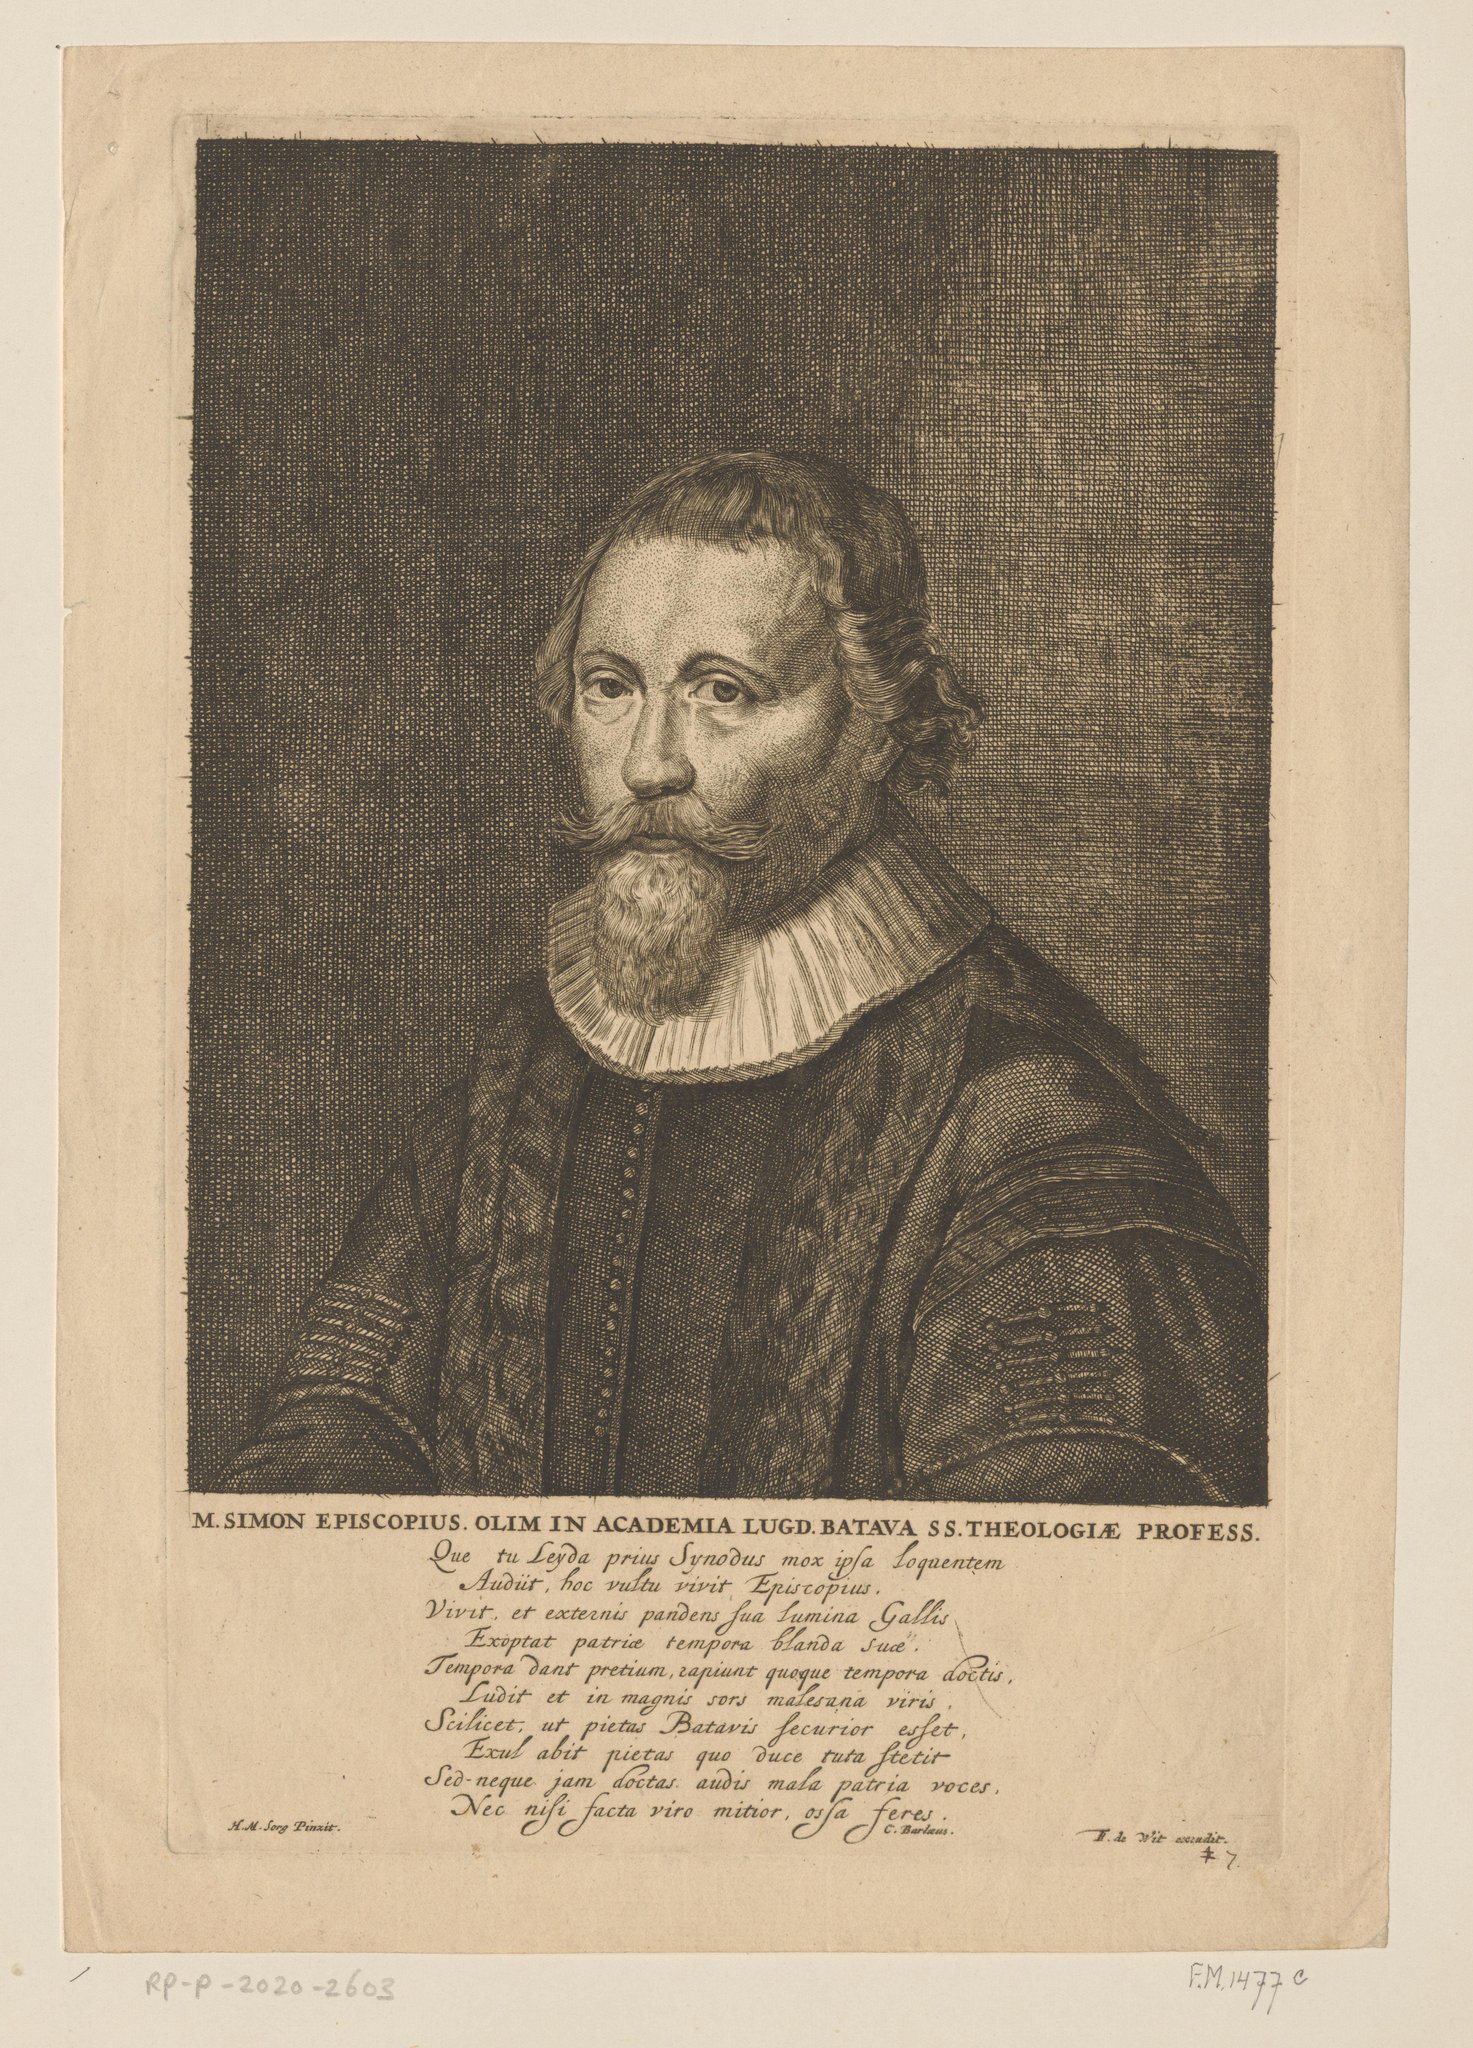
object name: print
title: Portret van Simon Episcopius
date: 1657-1706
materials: paper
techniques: engraving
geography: northern netherlands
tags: theologian, historical persons, professor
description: Met tienregelig vers in het Latijn onder het portret.